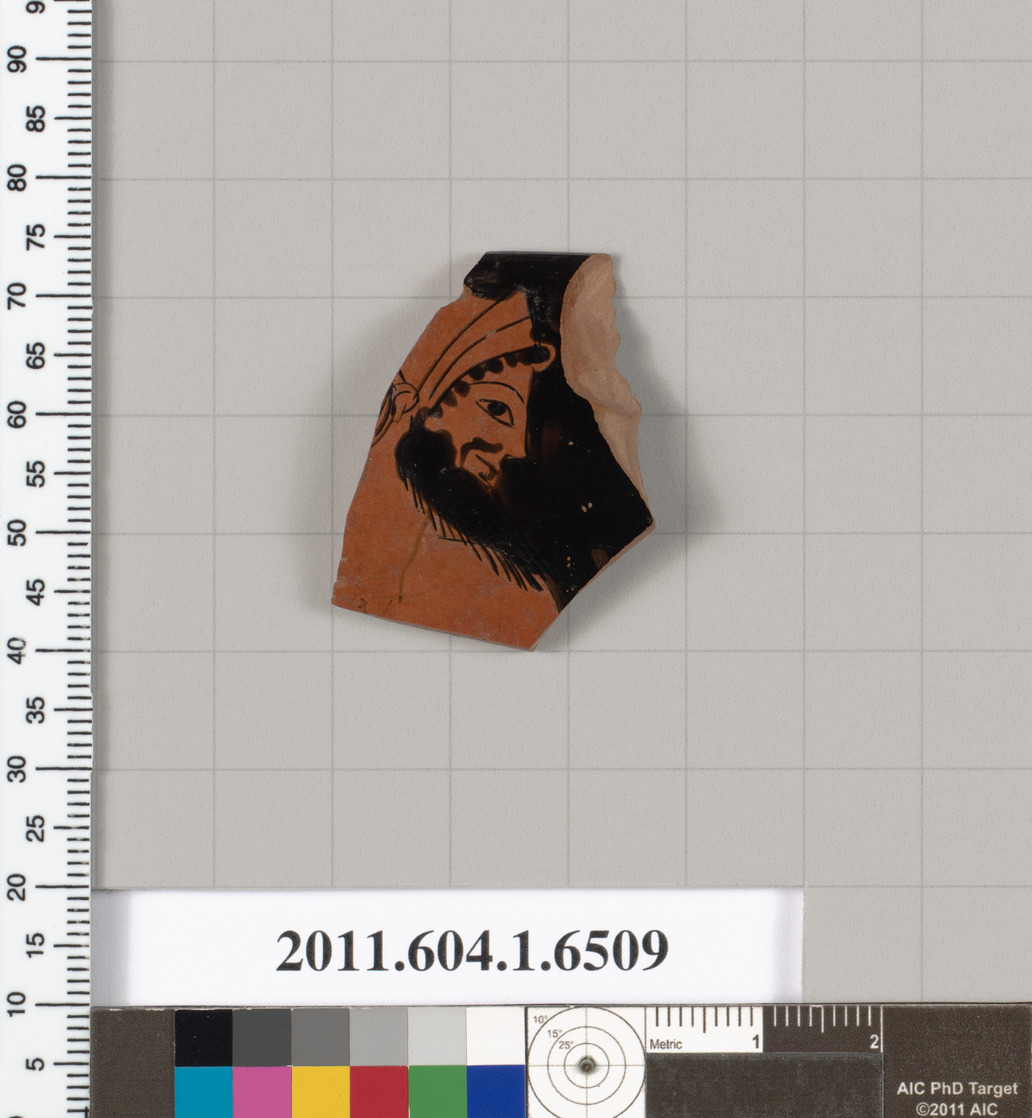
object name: kylix fragment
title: Terracotta rim fragment of a kylix (drinking cup)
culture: greek, attic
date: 490-480 BCE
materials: terracotta